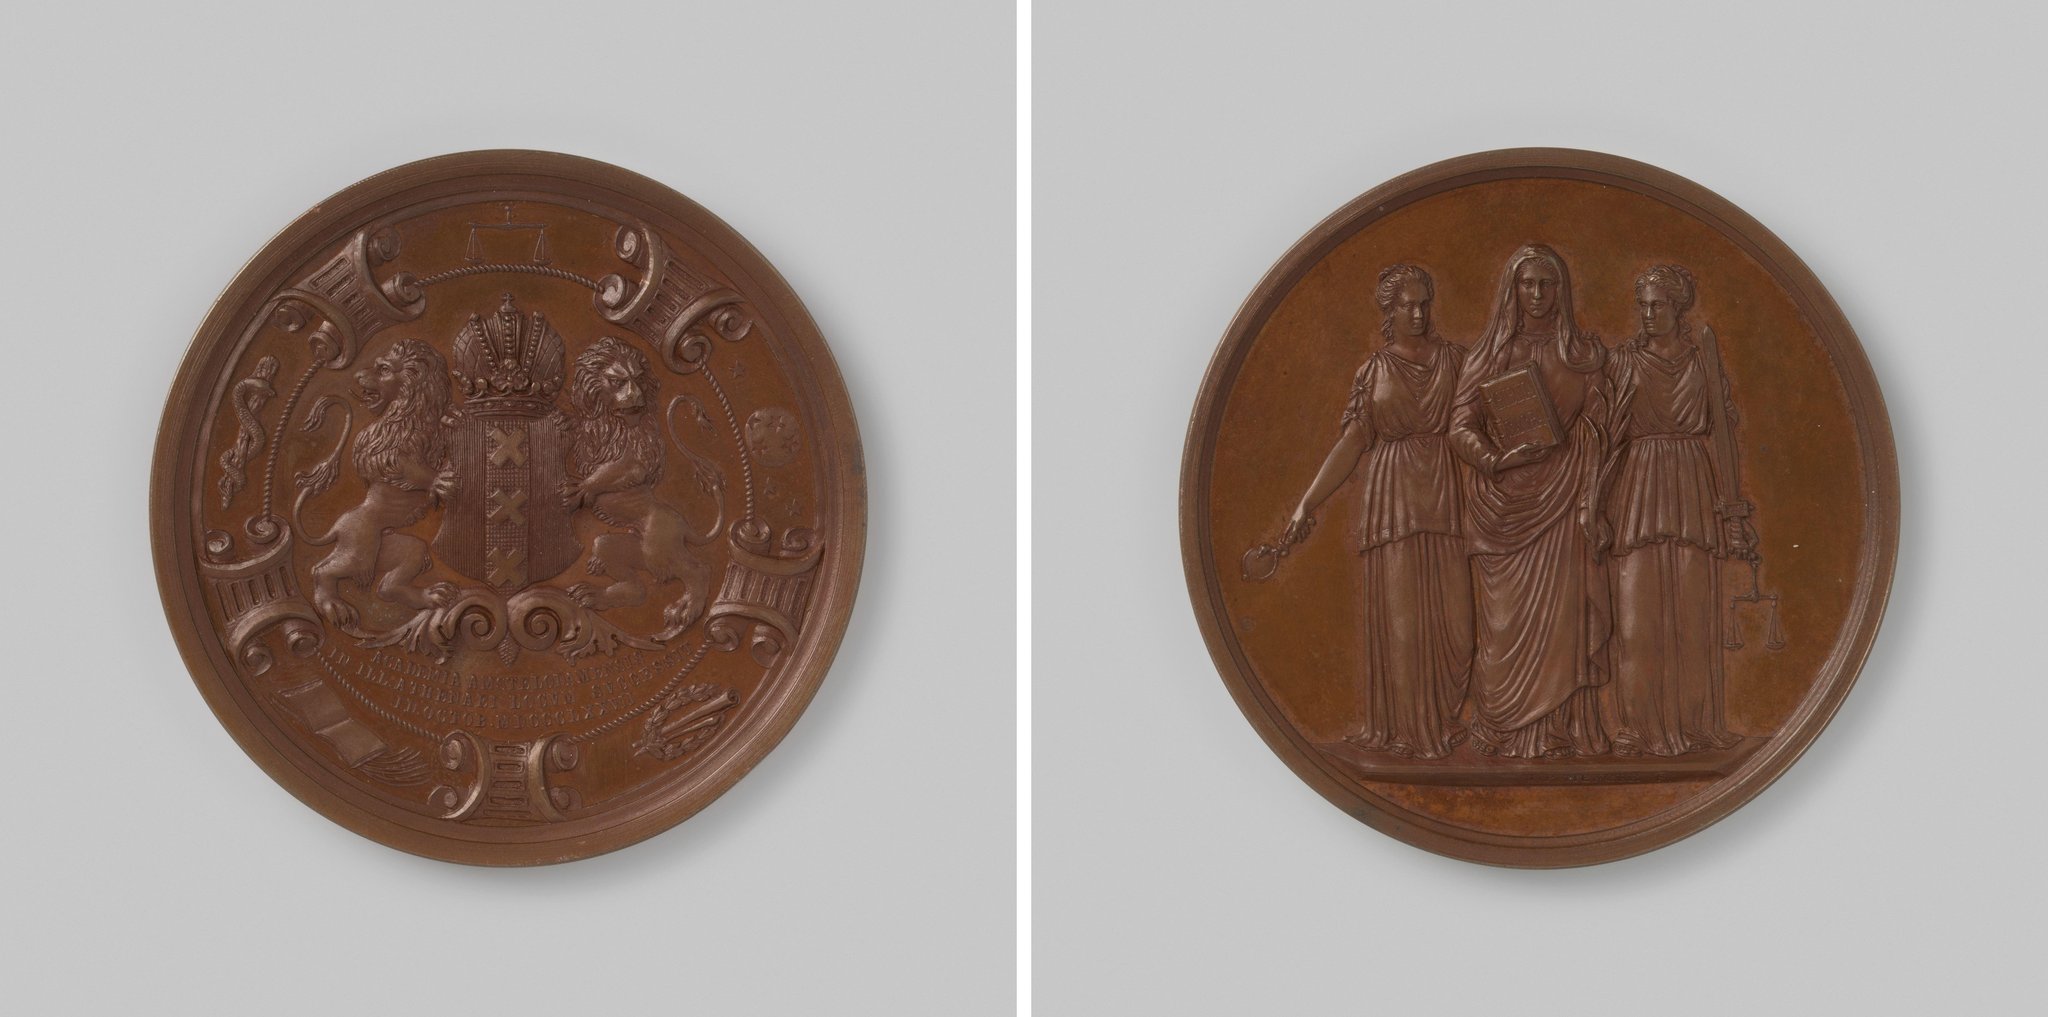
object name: medal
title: Athenaeum Illustre wordt gemeentelijke universiteit, 1877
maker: johan philip menger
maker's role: medailleur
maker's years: 1818-1895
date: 1877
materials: bronze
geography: utrecht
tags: amsterdam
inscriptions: inscription: ‘ACADEMIA AMSTELODAMENSIS IN ILL: ATHENAEI LOCVM SVCCESSIT ID.OCTOB.MDCCCLXXVII’, inscription: ‘BIBLIA SACRA’, signature: ‘J.P. MENGER F.’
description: Bronzen penning. Voorzijde: gekroond stadswapen van Amsterdam gehouden door twee leeuwen in een brede sierrand met vijf symbolen der faculteiten. Keerzijde: drie staande vrouwen op plint: Godsdienst, Justitia en Geneeskunde.